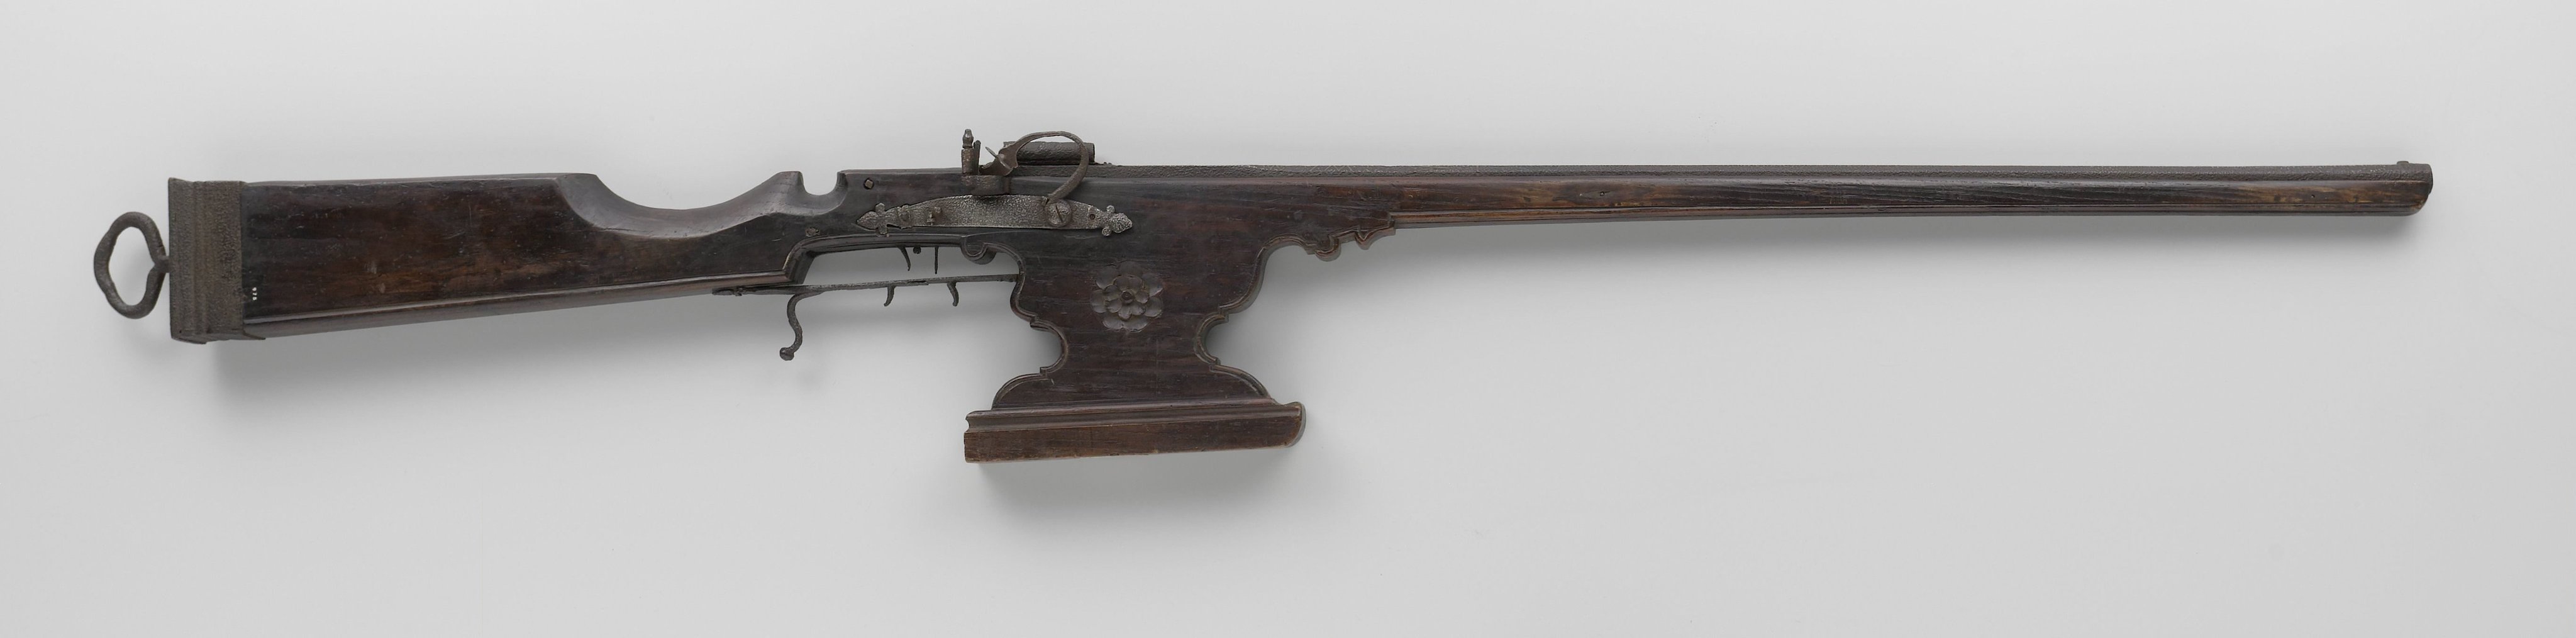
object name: target rifle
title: Target gun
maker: Anonymous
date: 1618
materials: copper, ink, iron, paper, wood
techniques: cutting, encrustation, soldering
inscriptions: inscription: ‘Dit s[?] is vant a[..] // [..]sie’, : ‘O; LA[..]WE[..]; 1618’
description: The operator of this heavy target gun would have rested the flat base of the support stand on a table or bench, allowing him to take careful aim. There are two indentations on the top of the stock. The smaller of these, to the front, is for the thumb of his right hand, while the rear indentation accommodated the fingers of his left hand. The gun could be suspended from the iron eyelet when not in use.